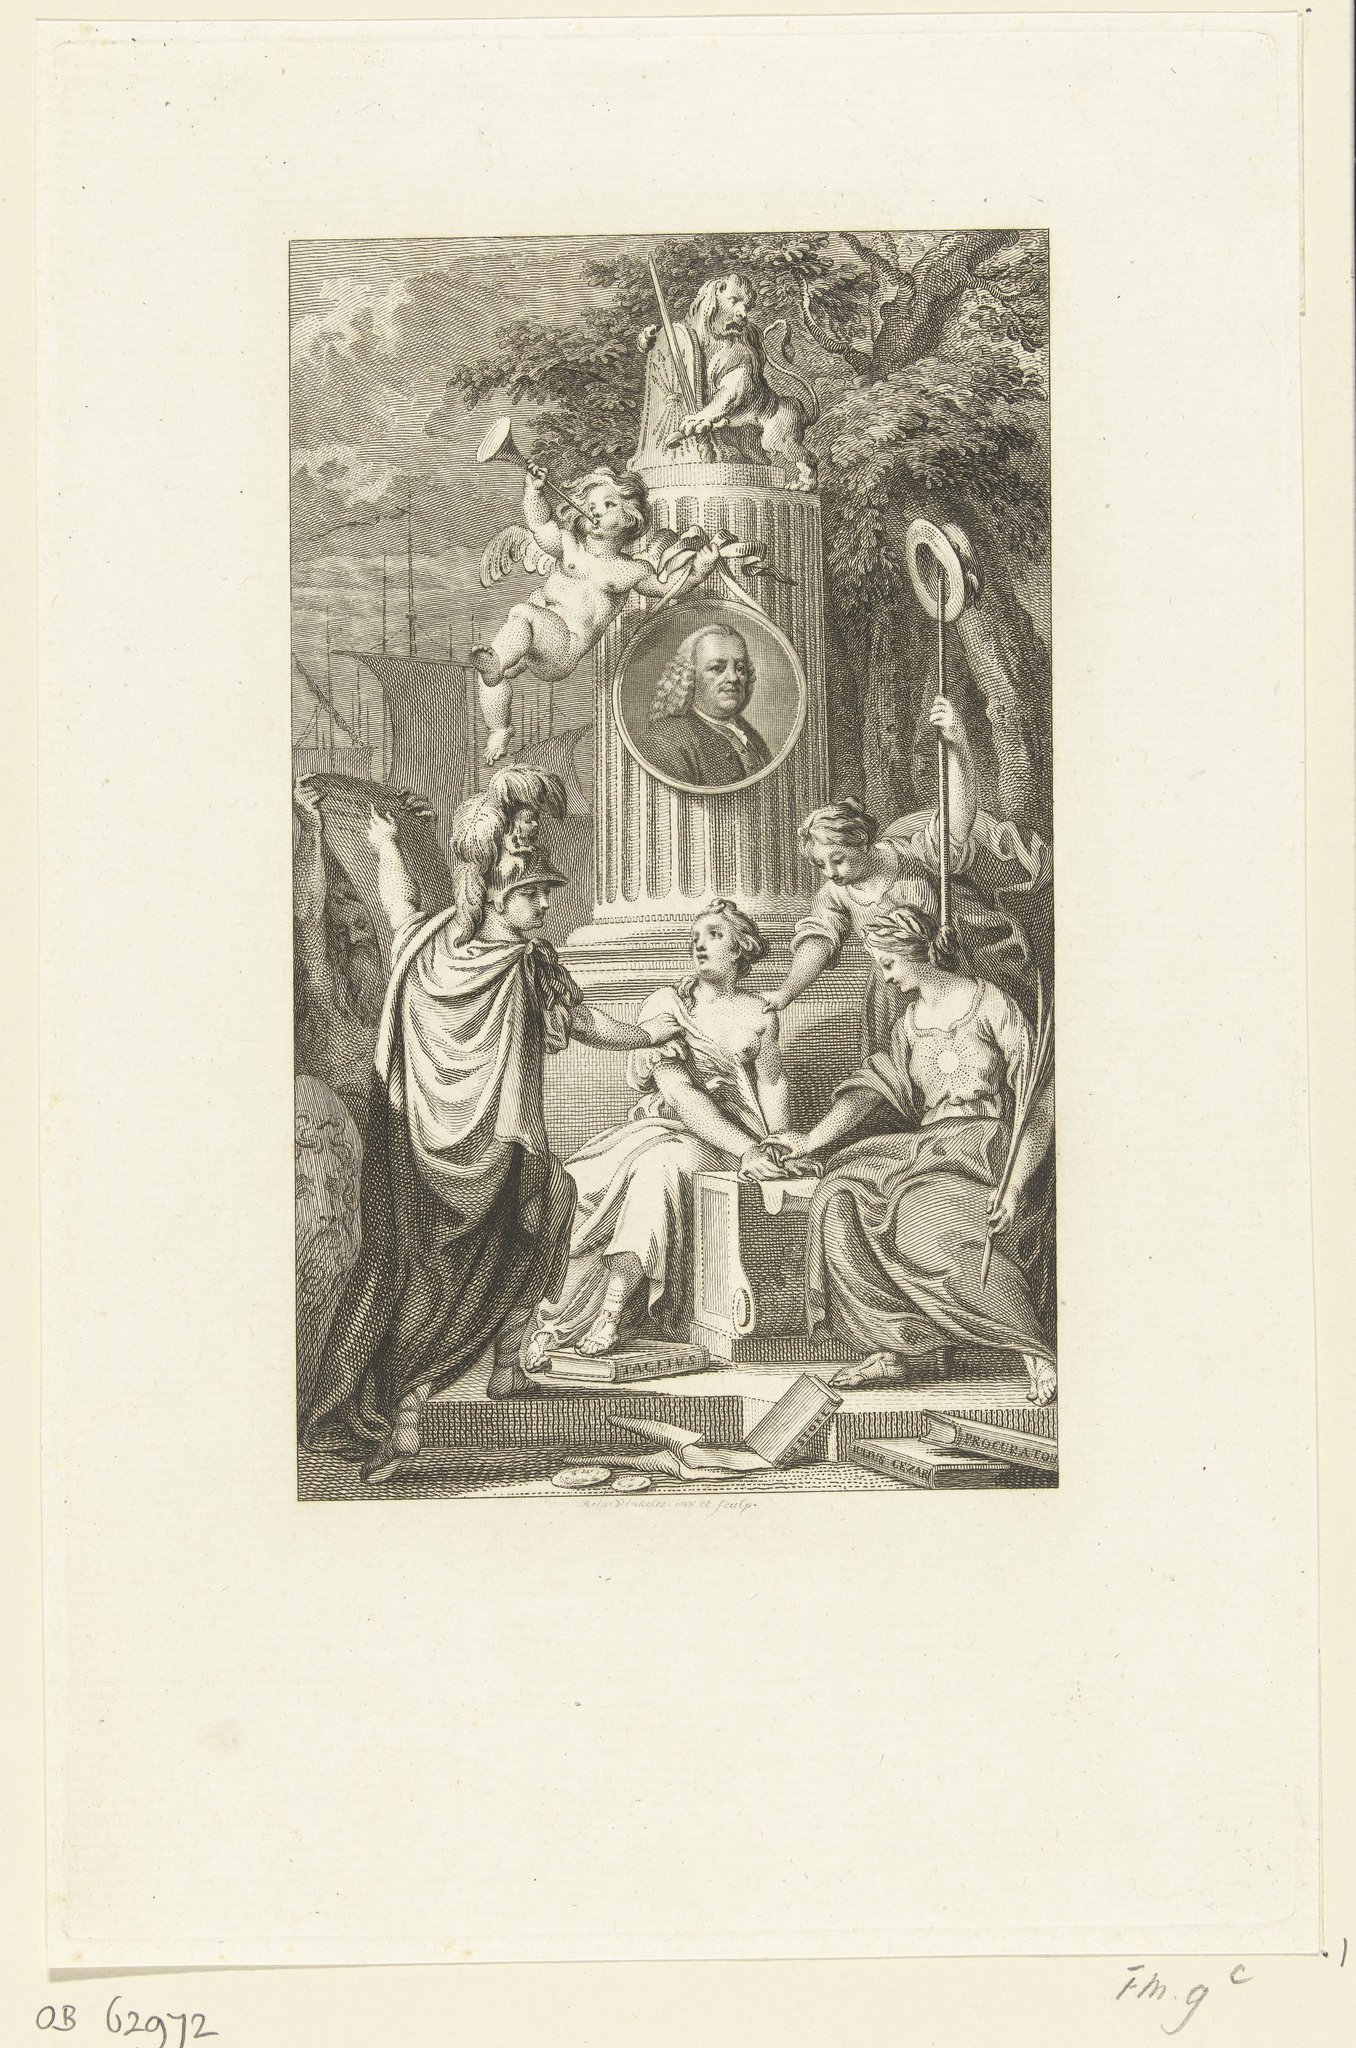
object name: titelblad, titelpagina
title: Titelpagina voor: J. Wagenaar, Vaderlandsche Historie, 1790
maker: reinier vinkeles (i)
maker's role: draughtsman, print maker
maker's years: 1741-1816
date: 1788-1790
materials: paper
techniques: engraving, etching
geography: amsterdam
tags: amsterdam, jan wagenaar, truth; 'verità' (ripa), 'historia'; 'historia' (ripa), freedom, liberty; 'libertà' (ripa)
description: Geschiedenis schrijft omringd door de Waarheid, Vrijheid en Minerva. Achter hen een zuil met het portret van de schrijver Jan Wagenaar.